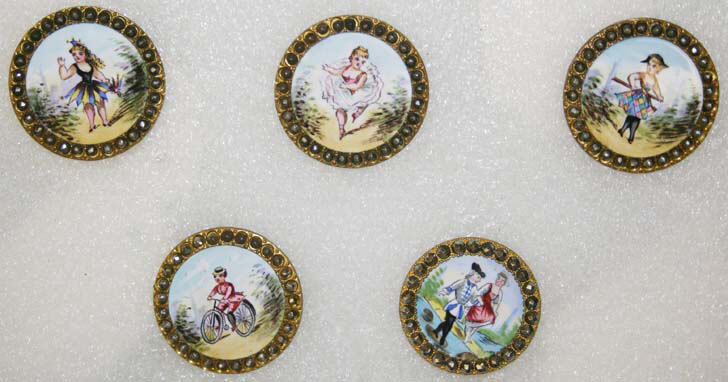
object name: button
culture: french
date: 1880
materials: enamel, metal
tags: men,women,bicycles